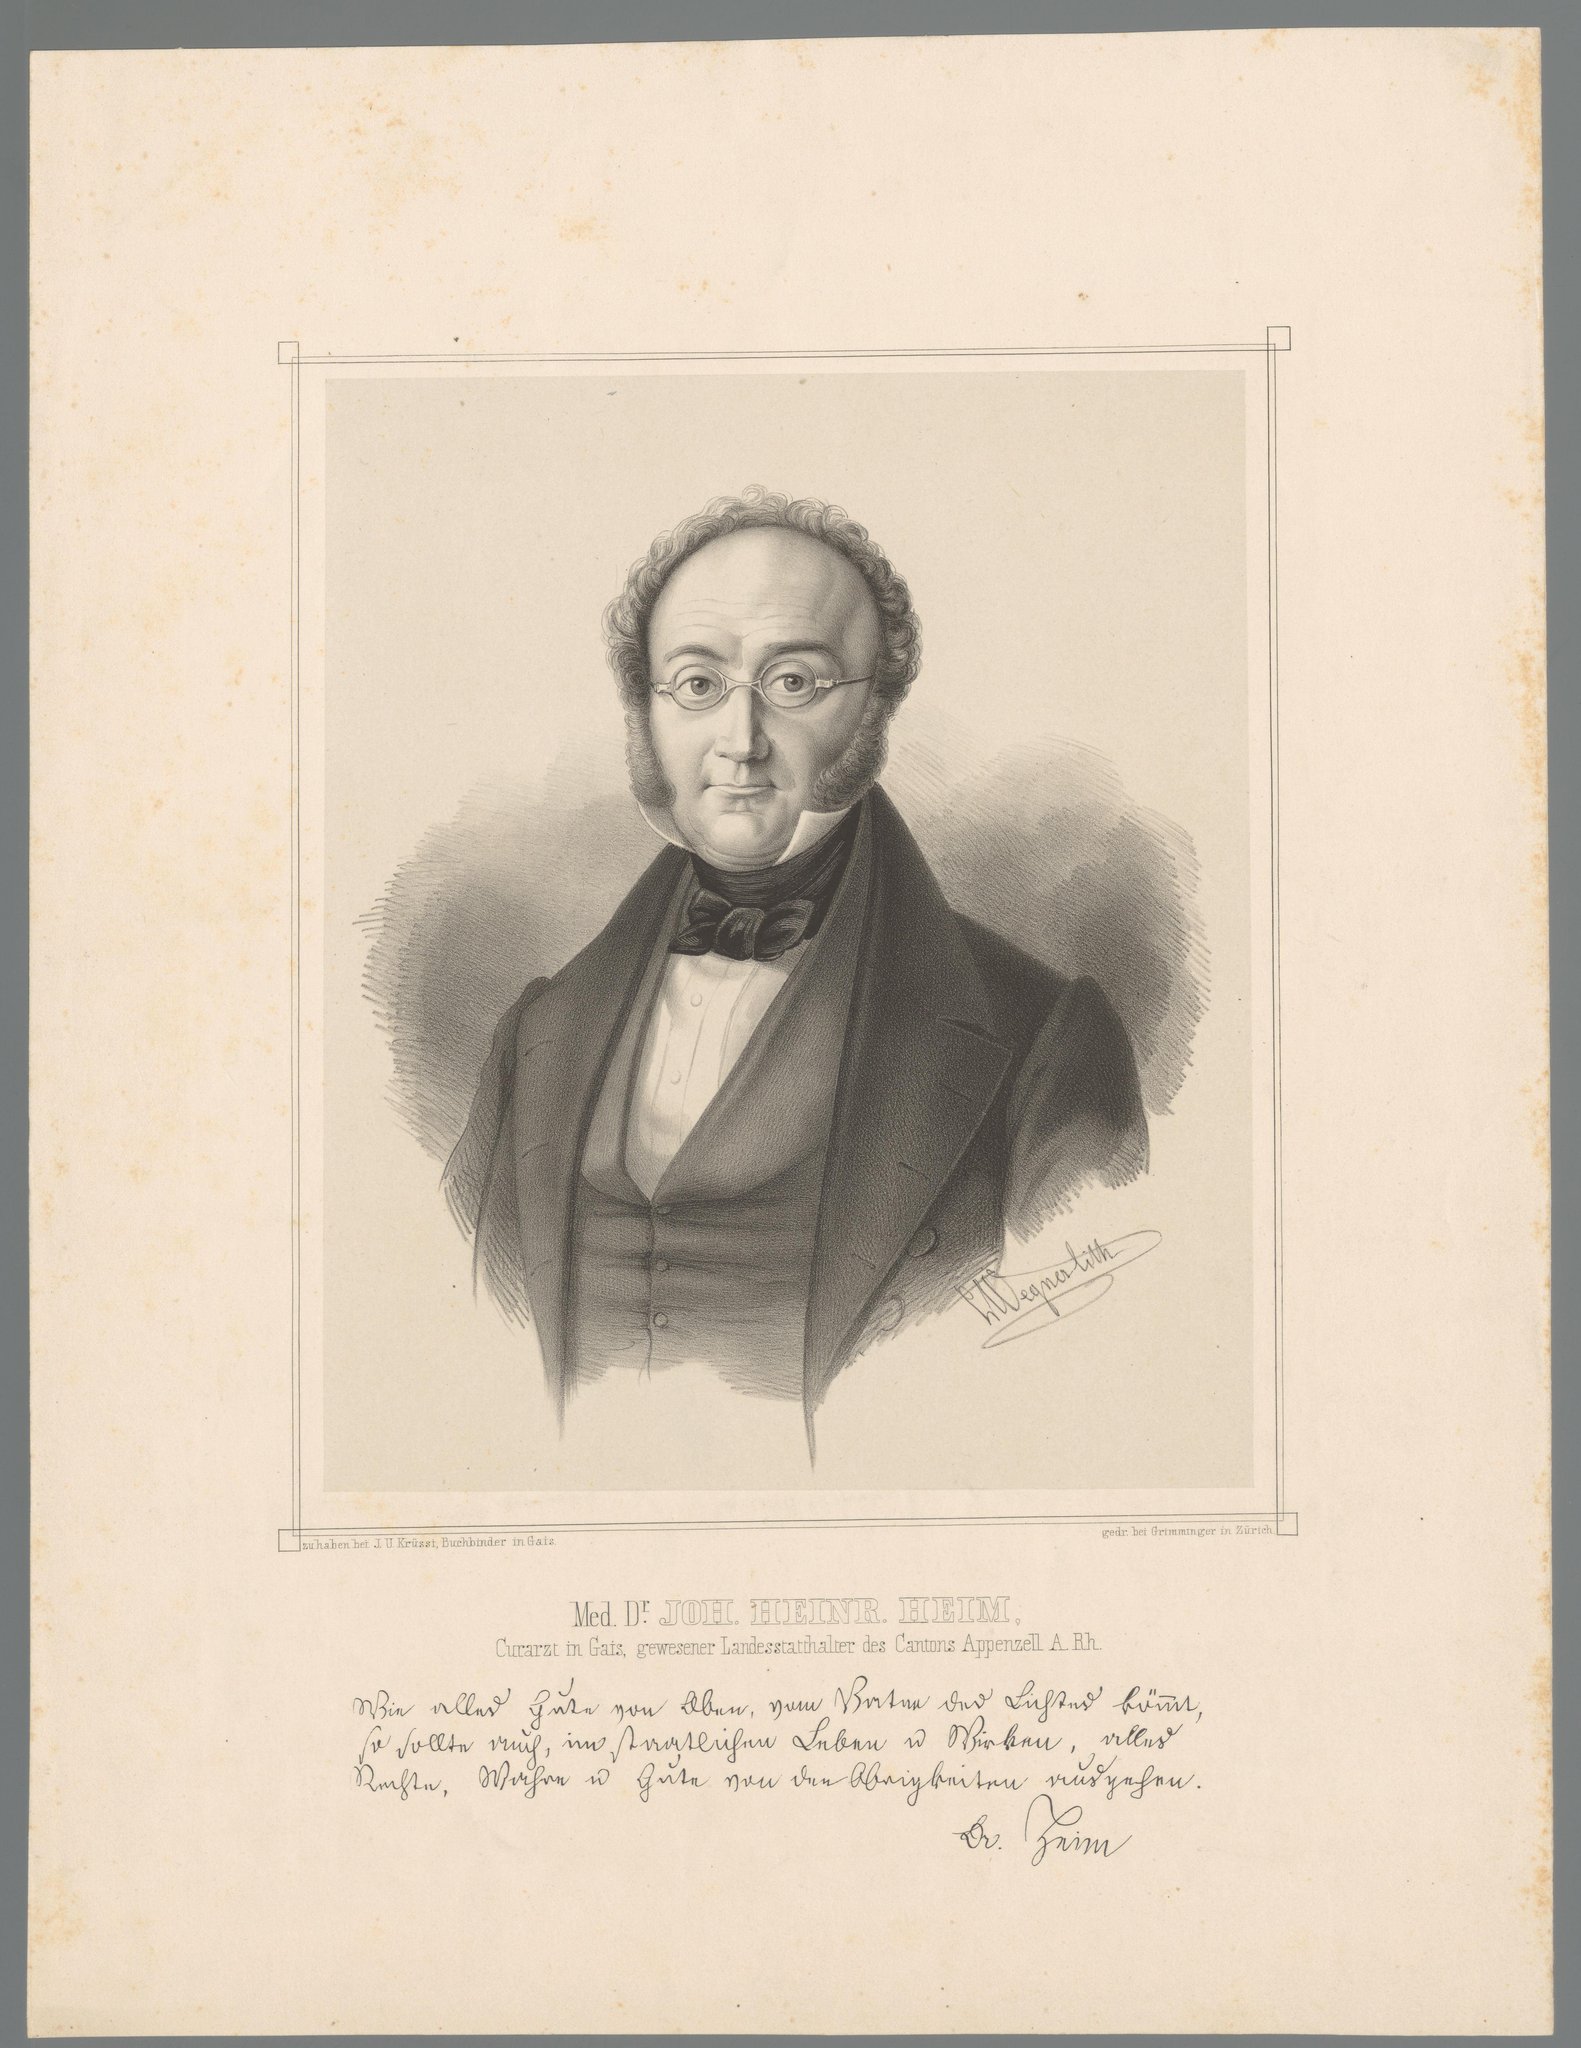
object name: print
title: Portret van Johann Heinrich Heim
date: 1826-1864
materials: paper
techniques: lithograph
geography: zurich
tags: adult man, historical persons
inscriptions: collector's mark: Lugt 2228